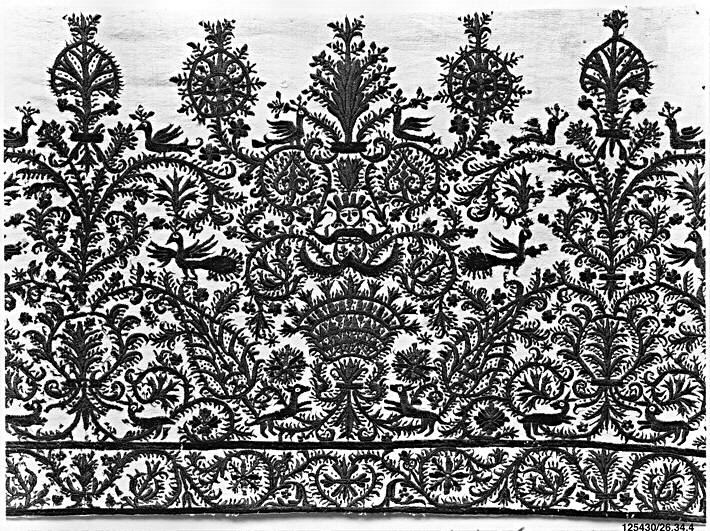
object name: border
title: Dress border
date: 1701-1800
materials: linen, silk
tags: human figures,animals,birds,flowers